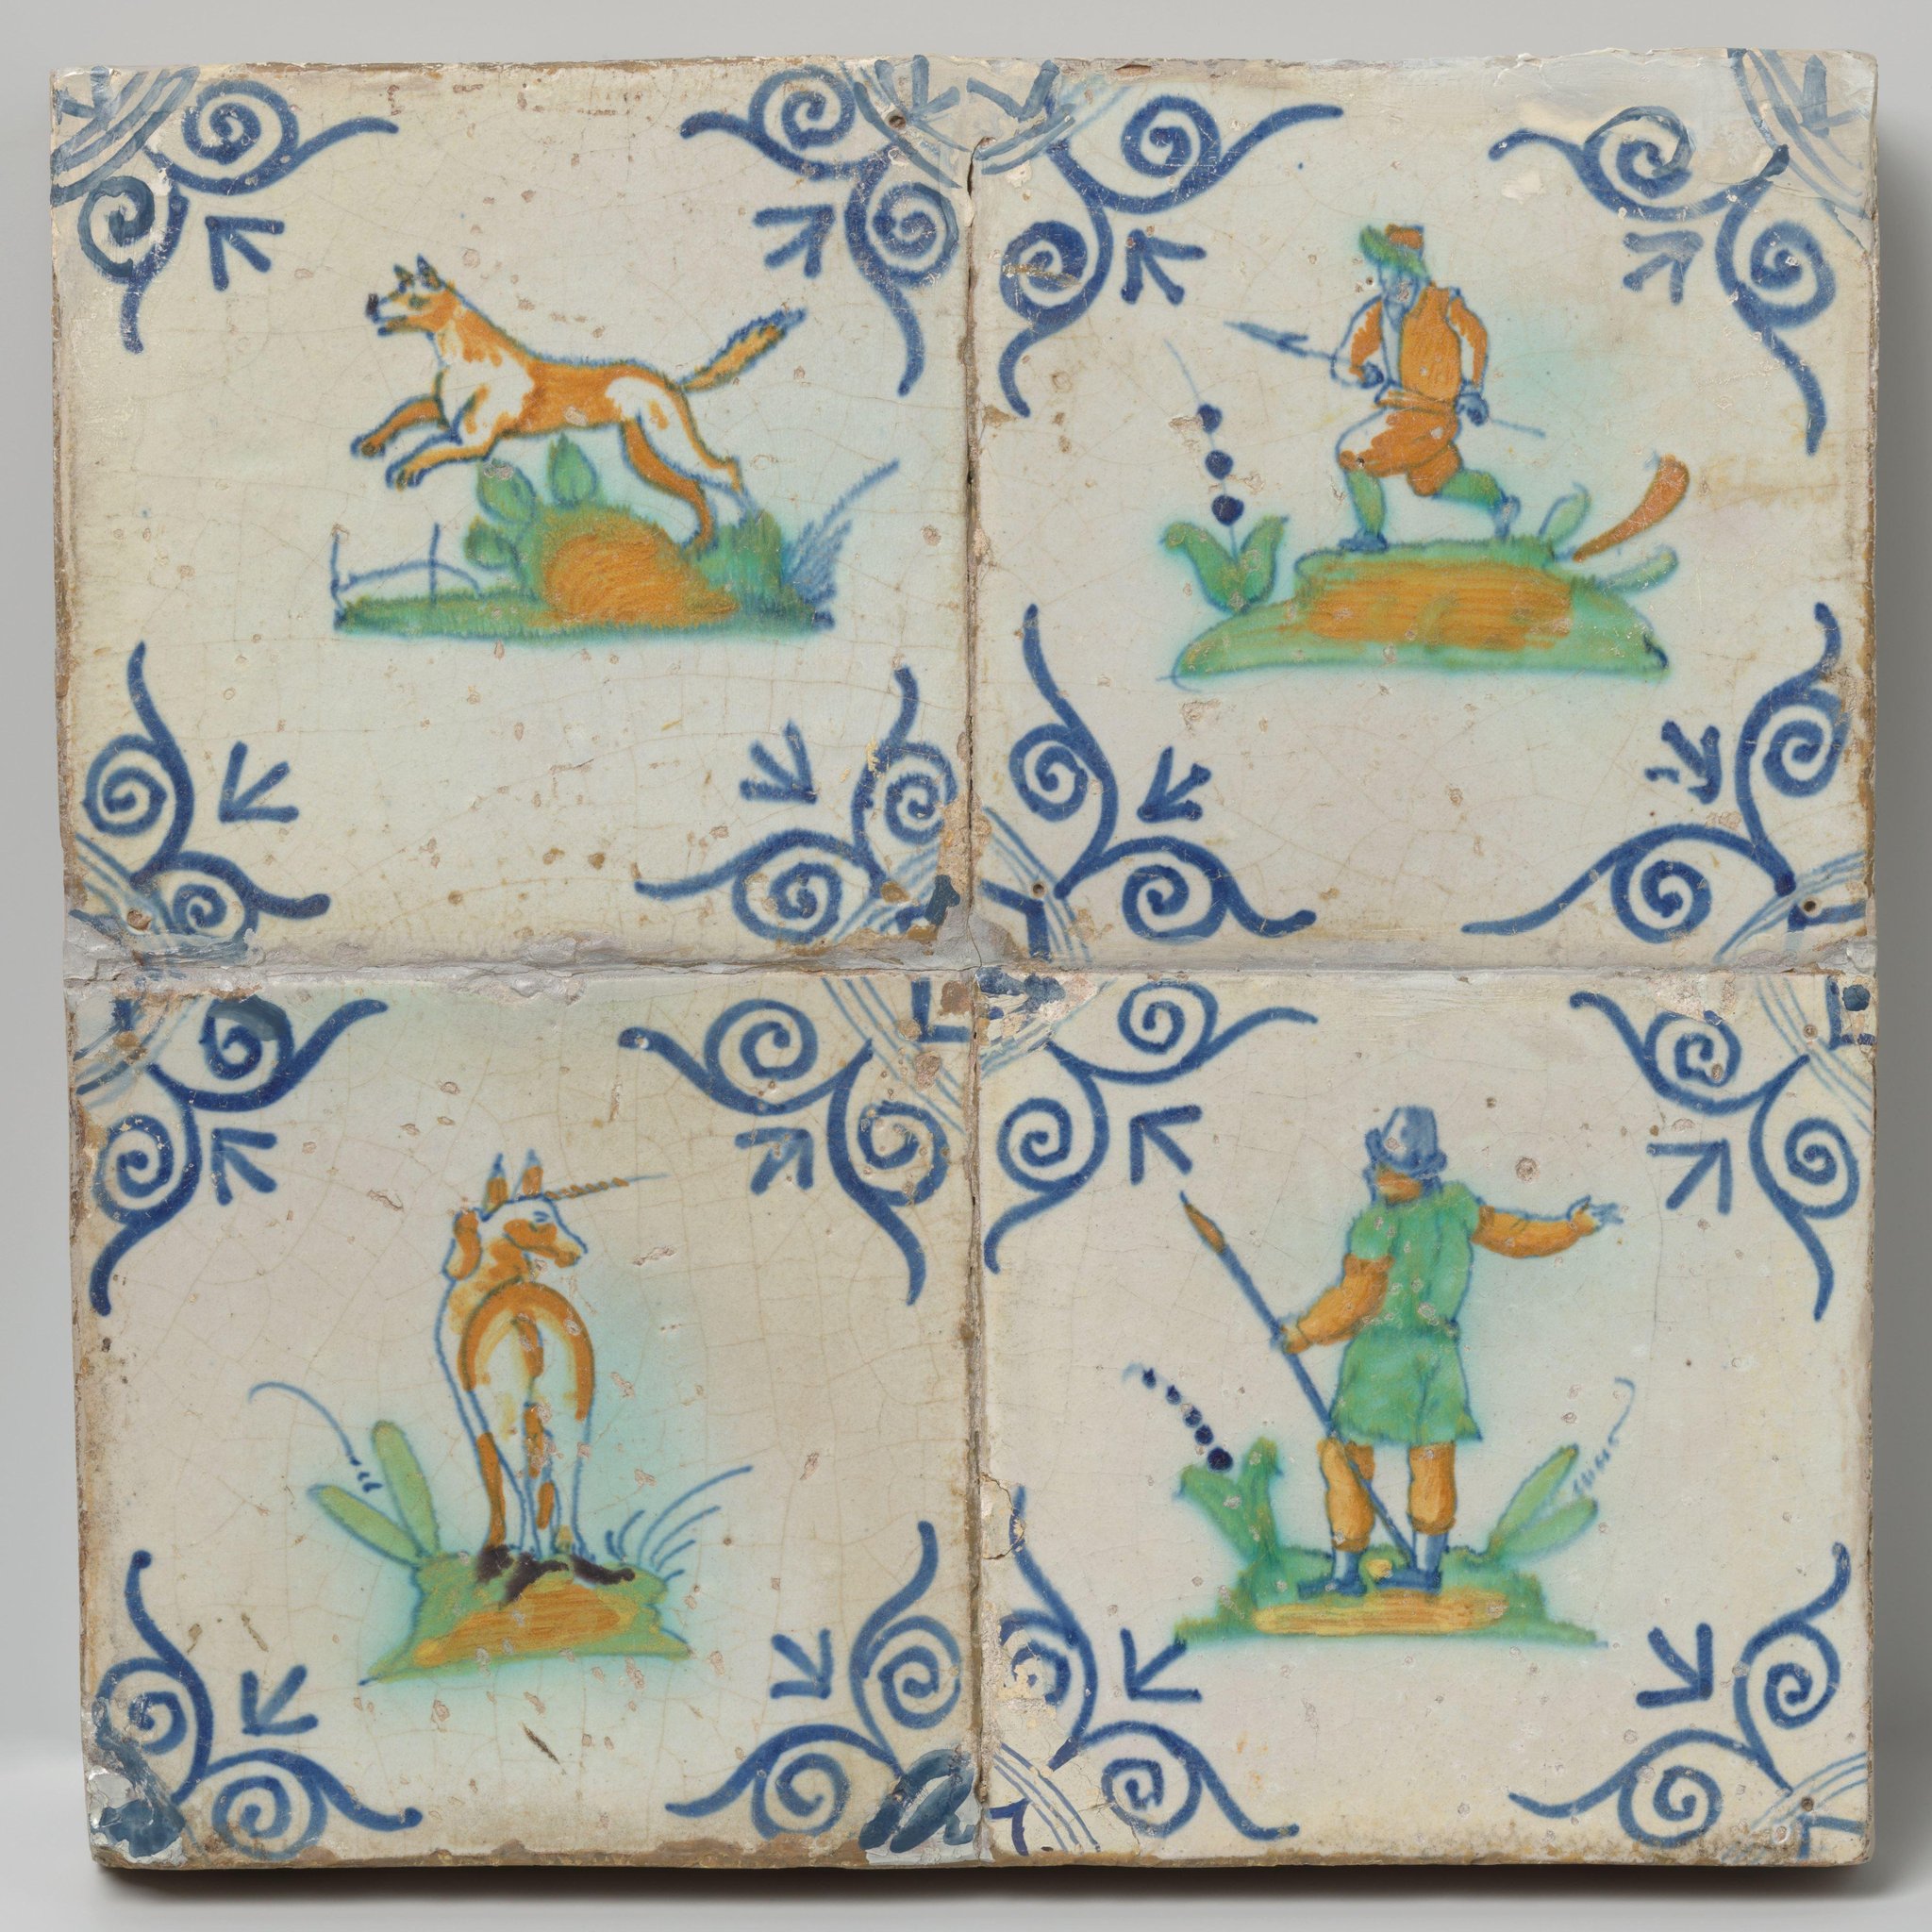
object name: diertegel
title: Veld van vier tegels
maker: Anonymous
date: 1635-1670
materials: earthenware, glaze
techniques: maiolica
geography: netherlands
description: Veld van 4 tegels (2 x 2) elk met een veelkleurig (blauw, groen, geel, oranje en paars) geschilderd dier of jager op een grond. In de hoeken, een ossenkop.